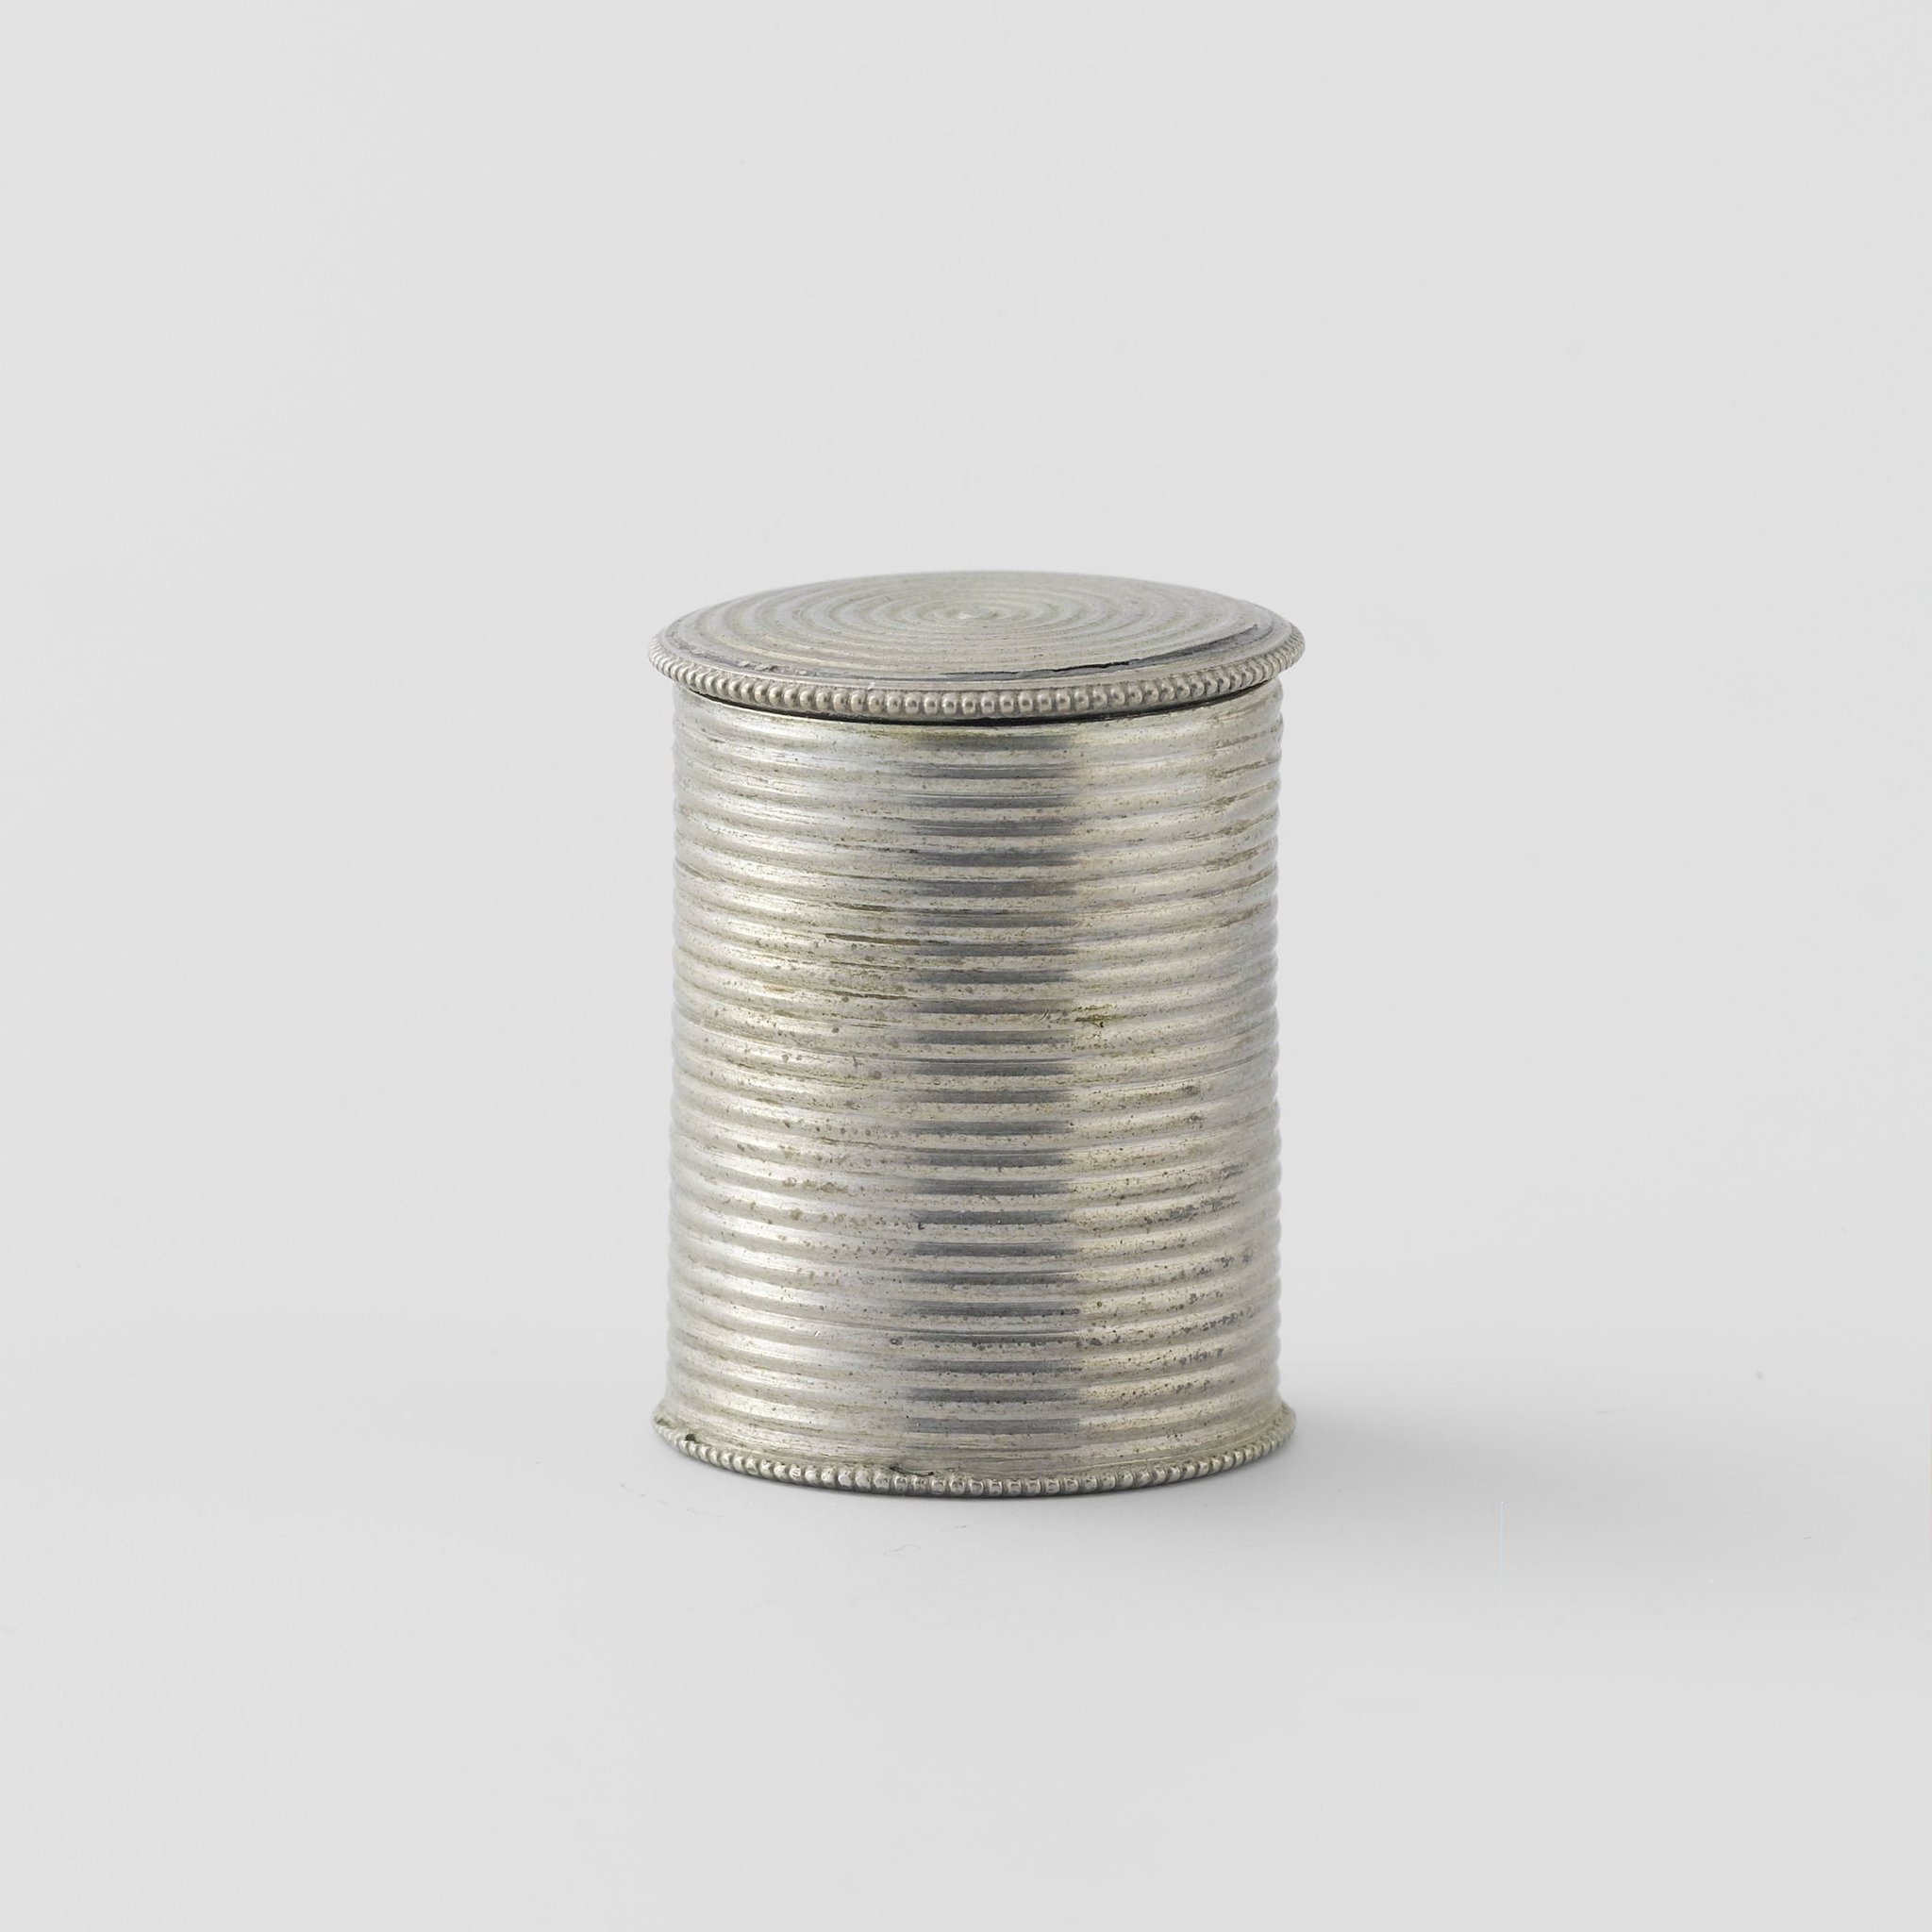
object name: miniature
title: Muntendoos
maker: Anonymous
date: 1800-1825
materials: silver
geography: netherlands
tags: container of precious metal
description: Cilindrische muntendoos met een platte deksel. De rand van het deksel is afgezet met een parelrand evenals de onderrand van de doos. Het deksel en de onderzijde hebben concentrische ribbels. De zijwand van de doos heeft horizontale ribbels. De doos is gemerkt met een zwaardje.